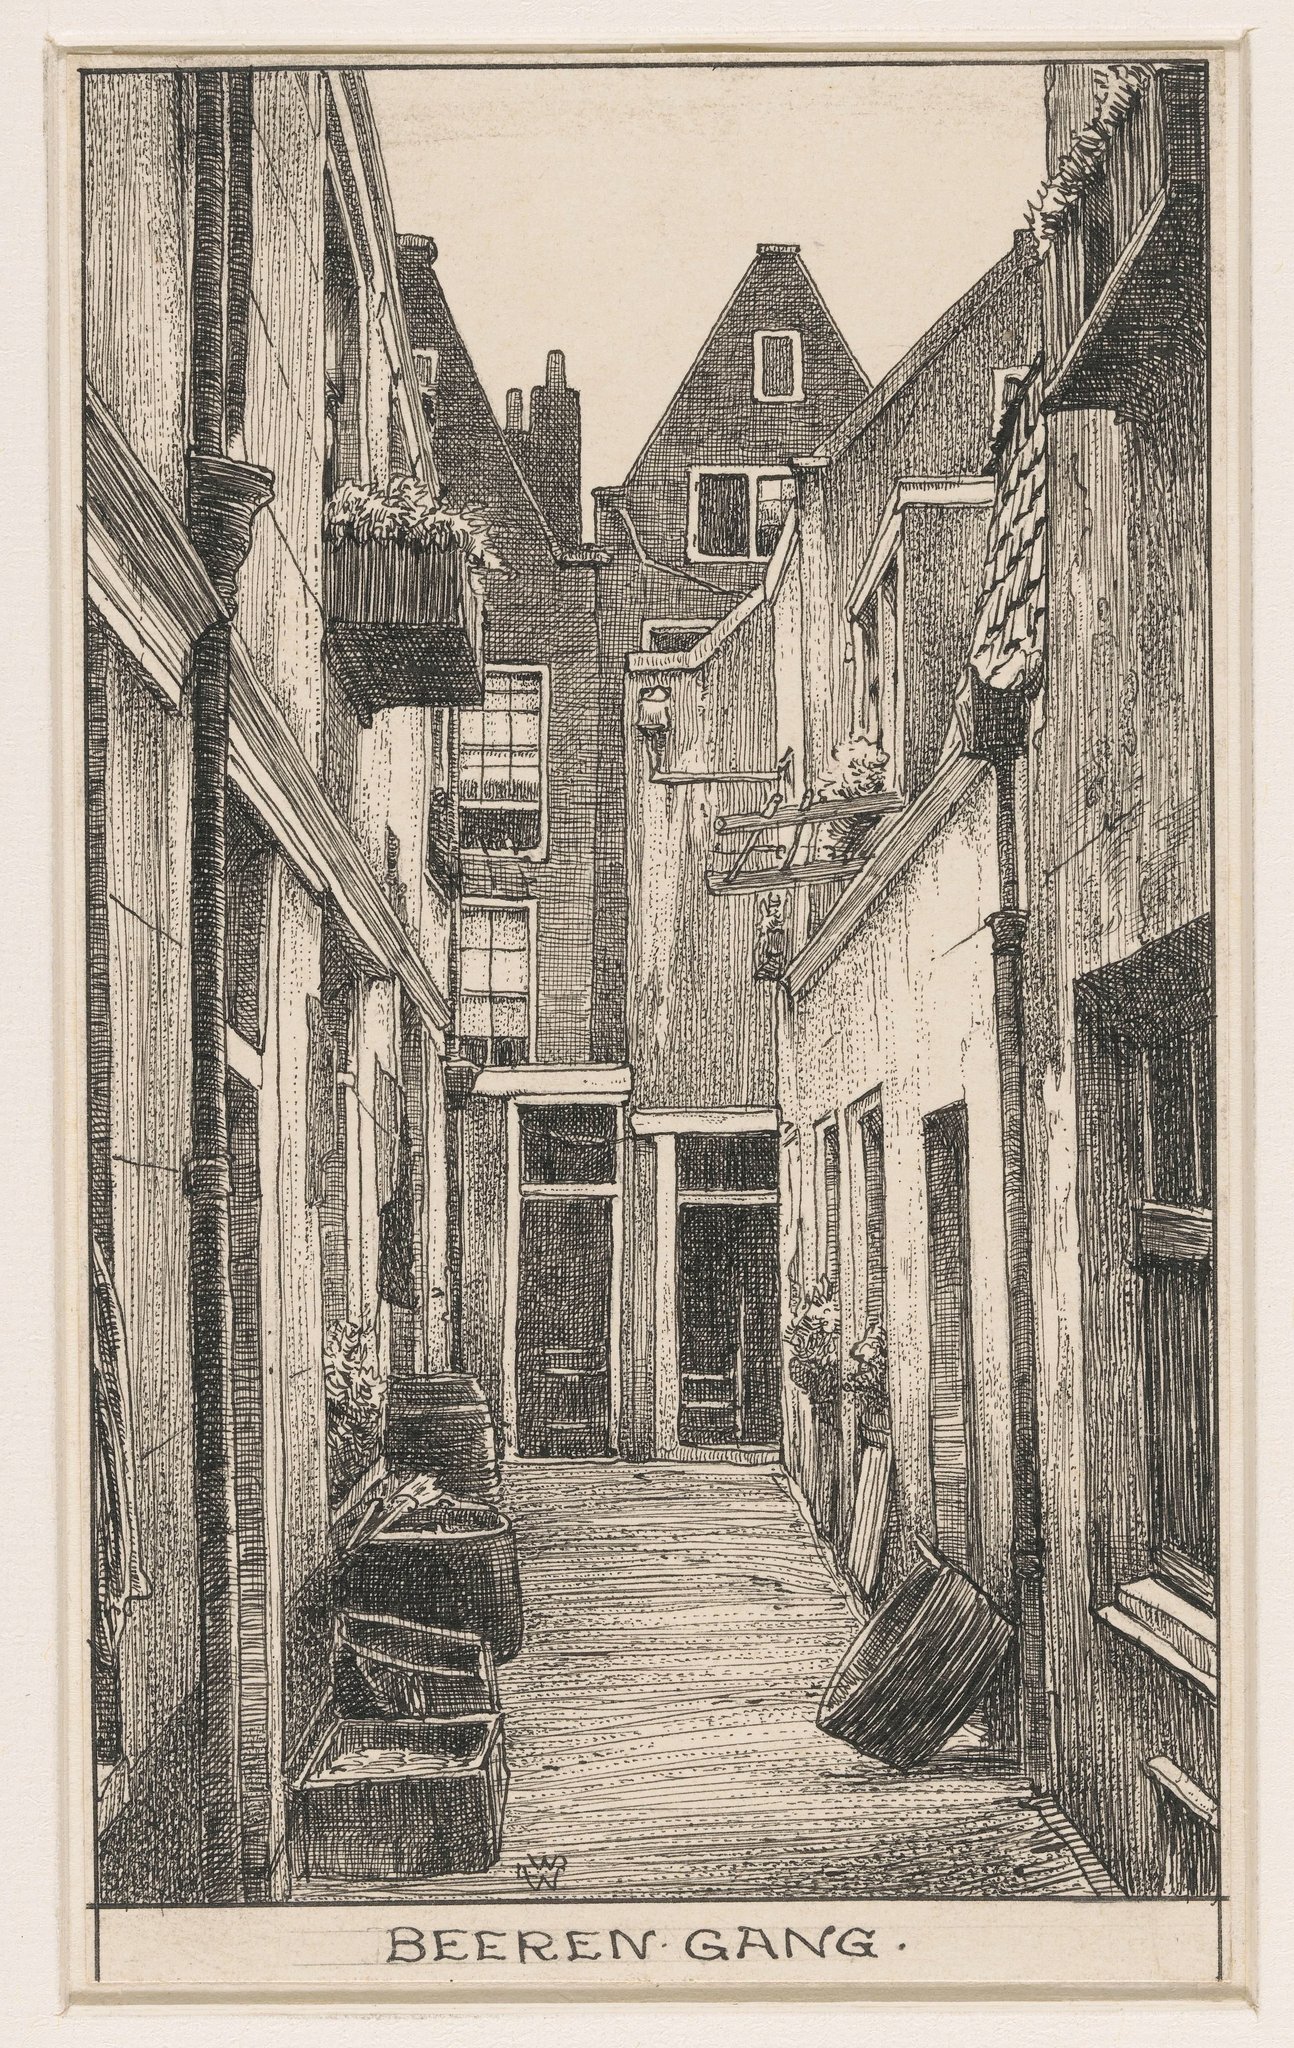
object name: drawing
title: Beeren Gang te Amsterdam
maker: willem wenckebach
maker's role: designer, draughtsman, painter, print maker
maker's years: 1860-1937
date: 1870-1926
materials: ink, paper, pencil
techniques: pen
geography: amsterdam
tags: lane, alley, amsterdam